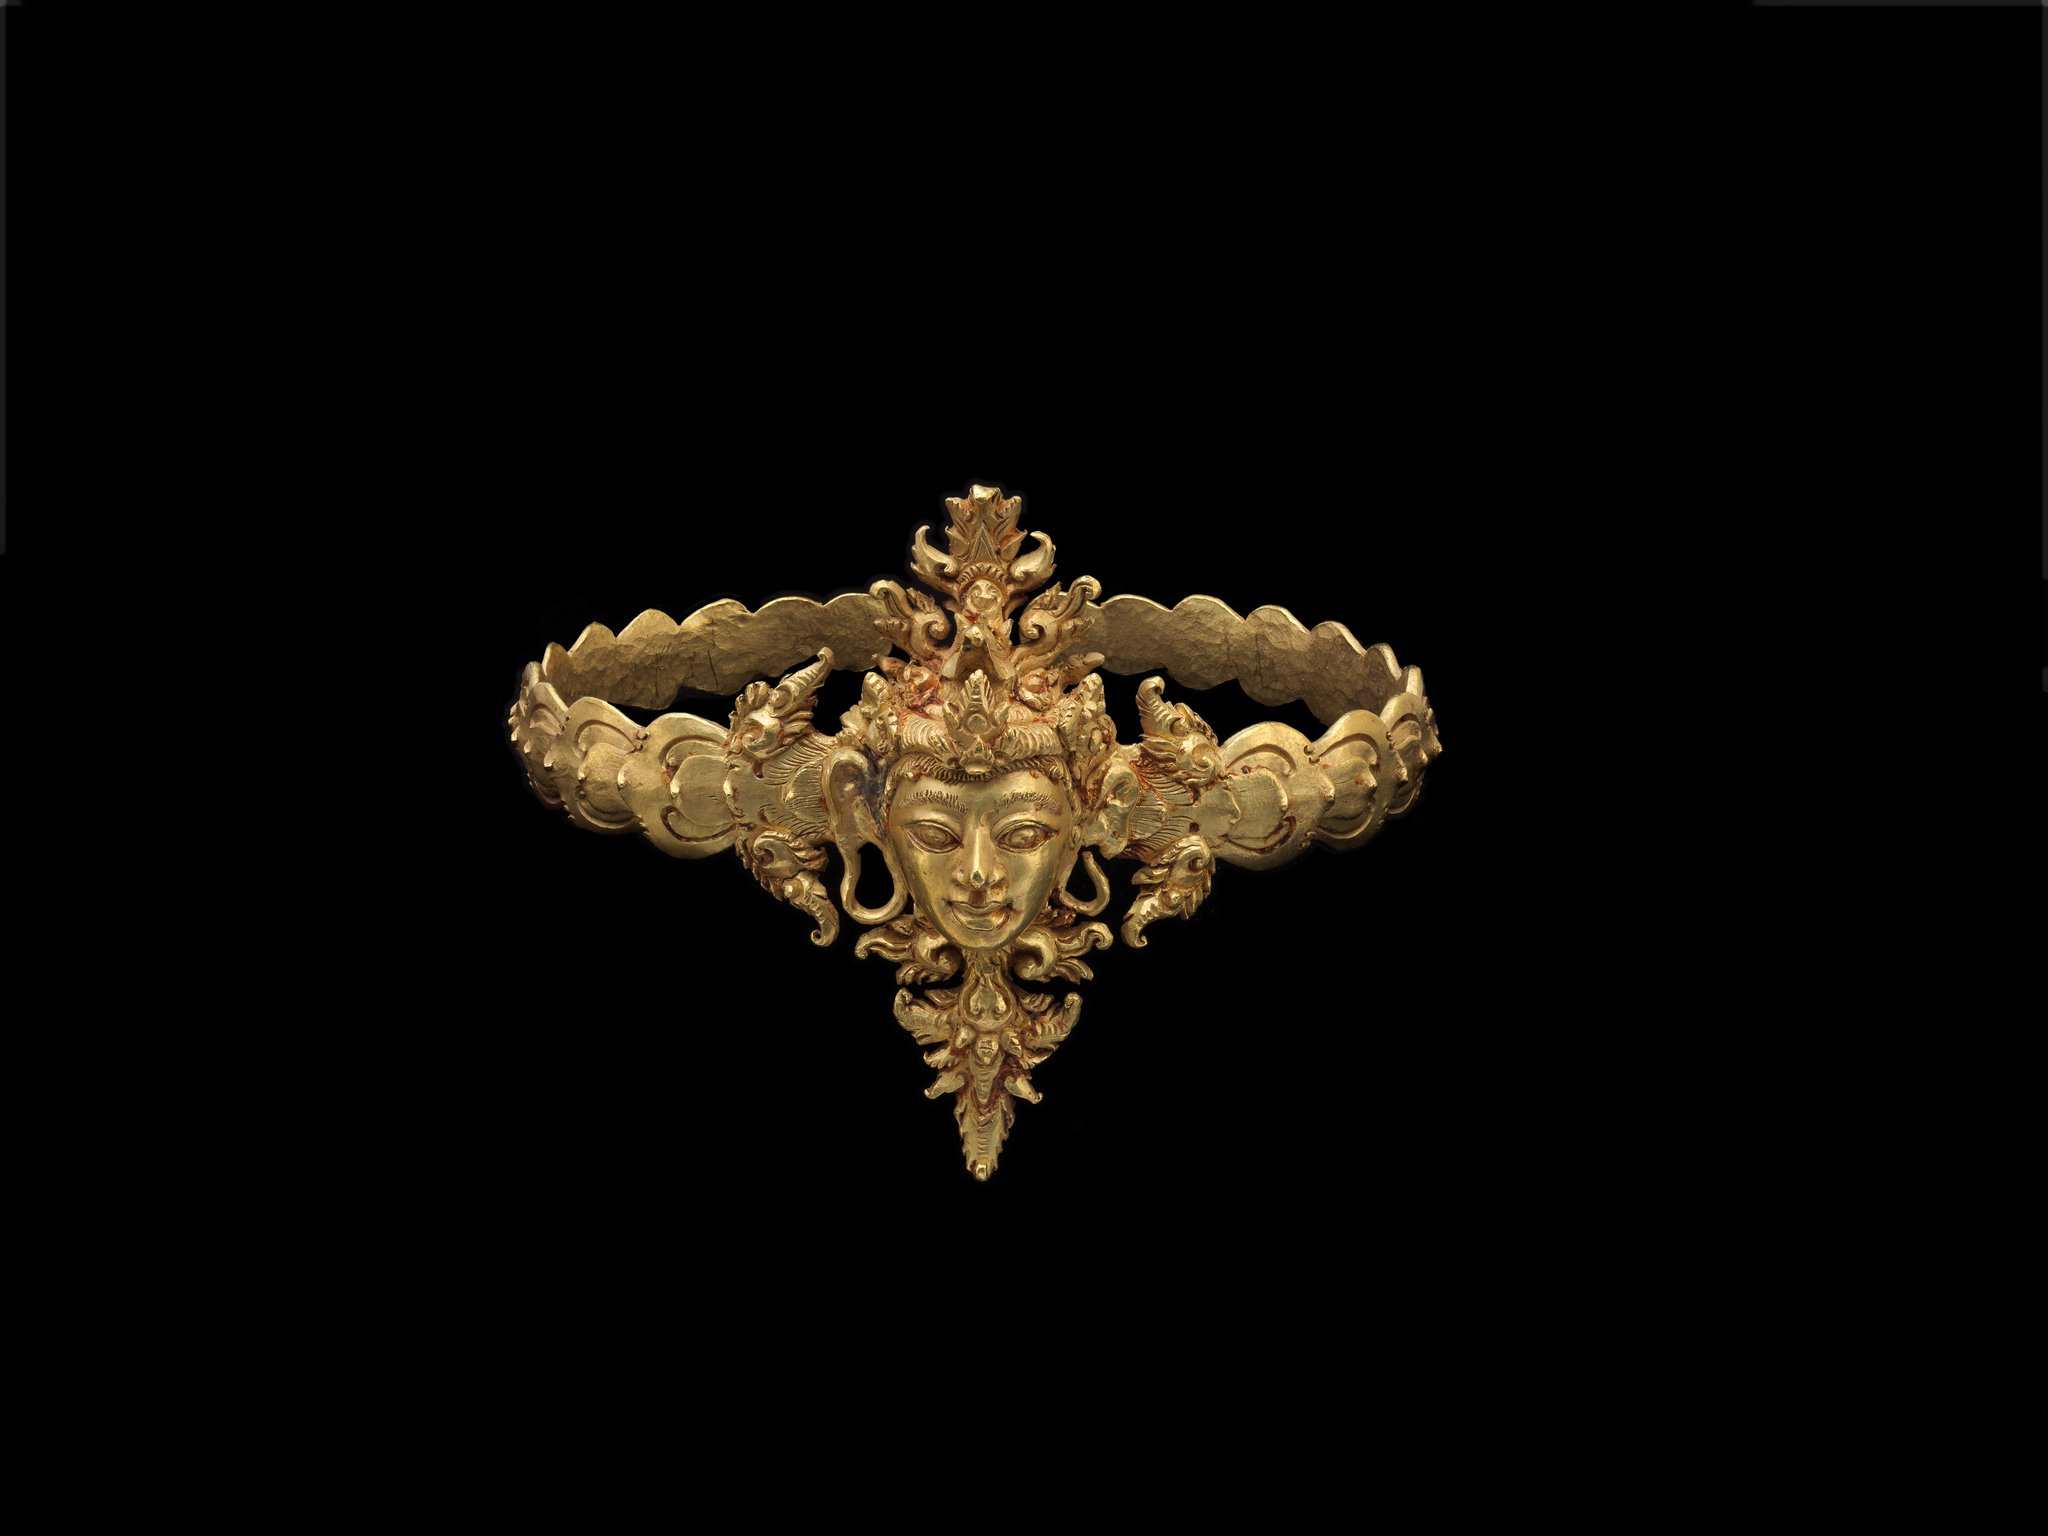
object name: armband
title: Arm Band with Man's Head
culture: indonesian, javanese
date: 901-925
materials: gold